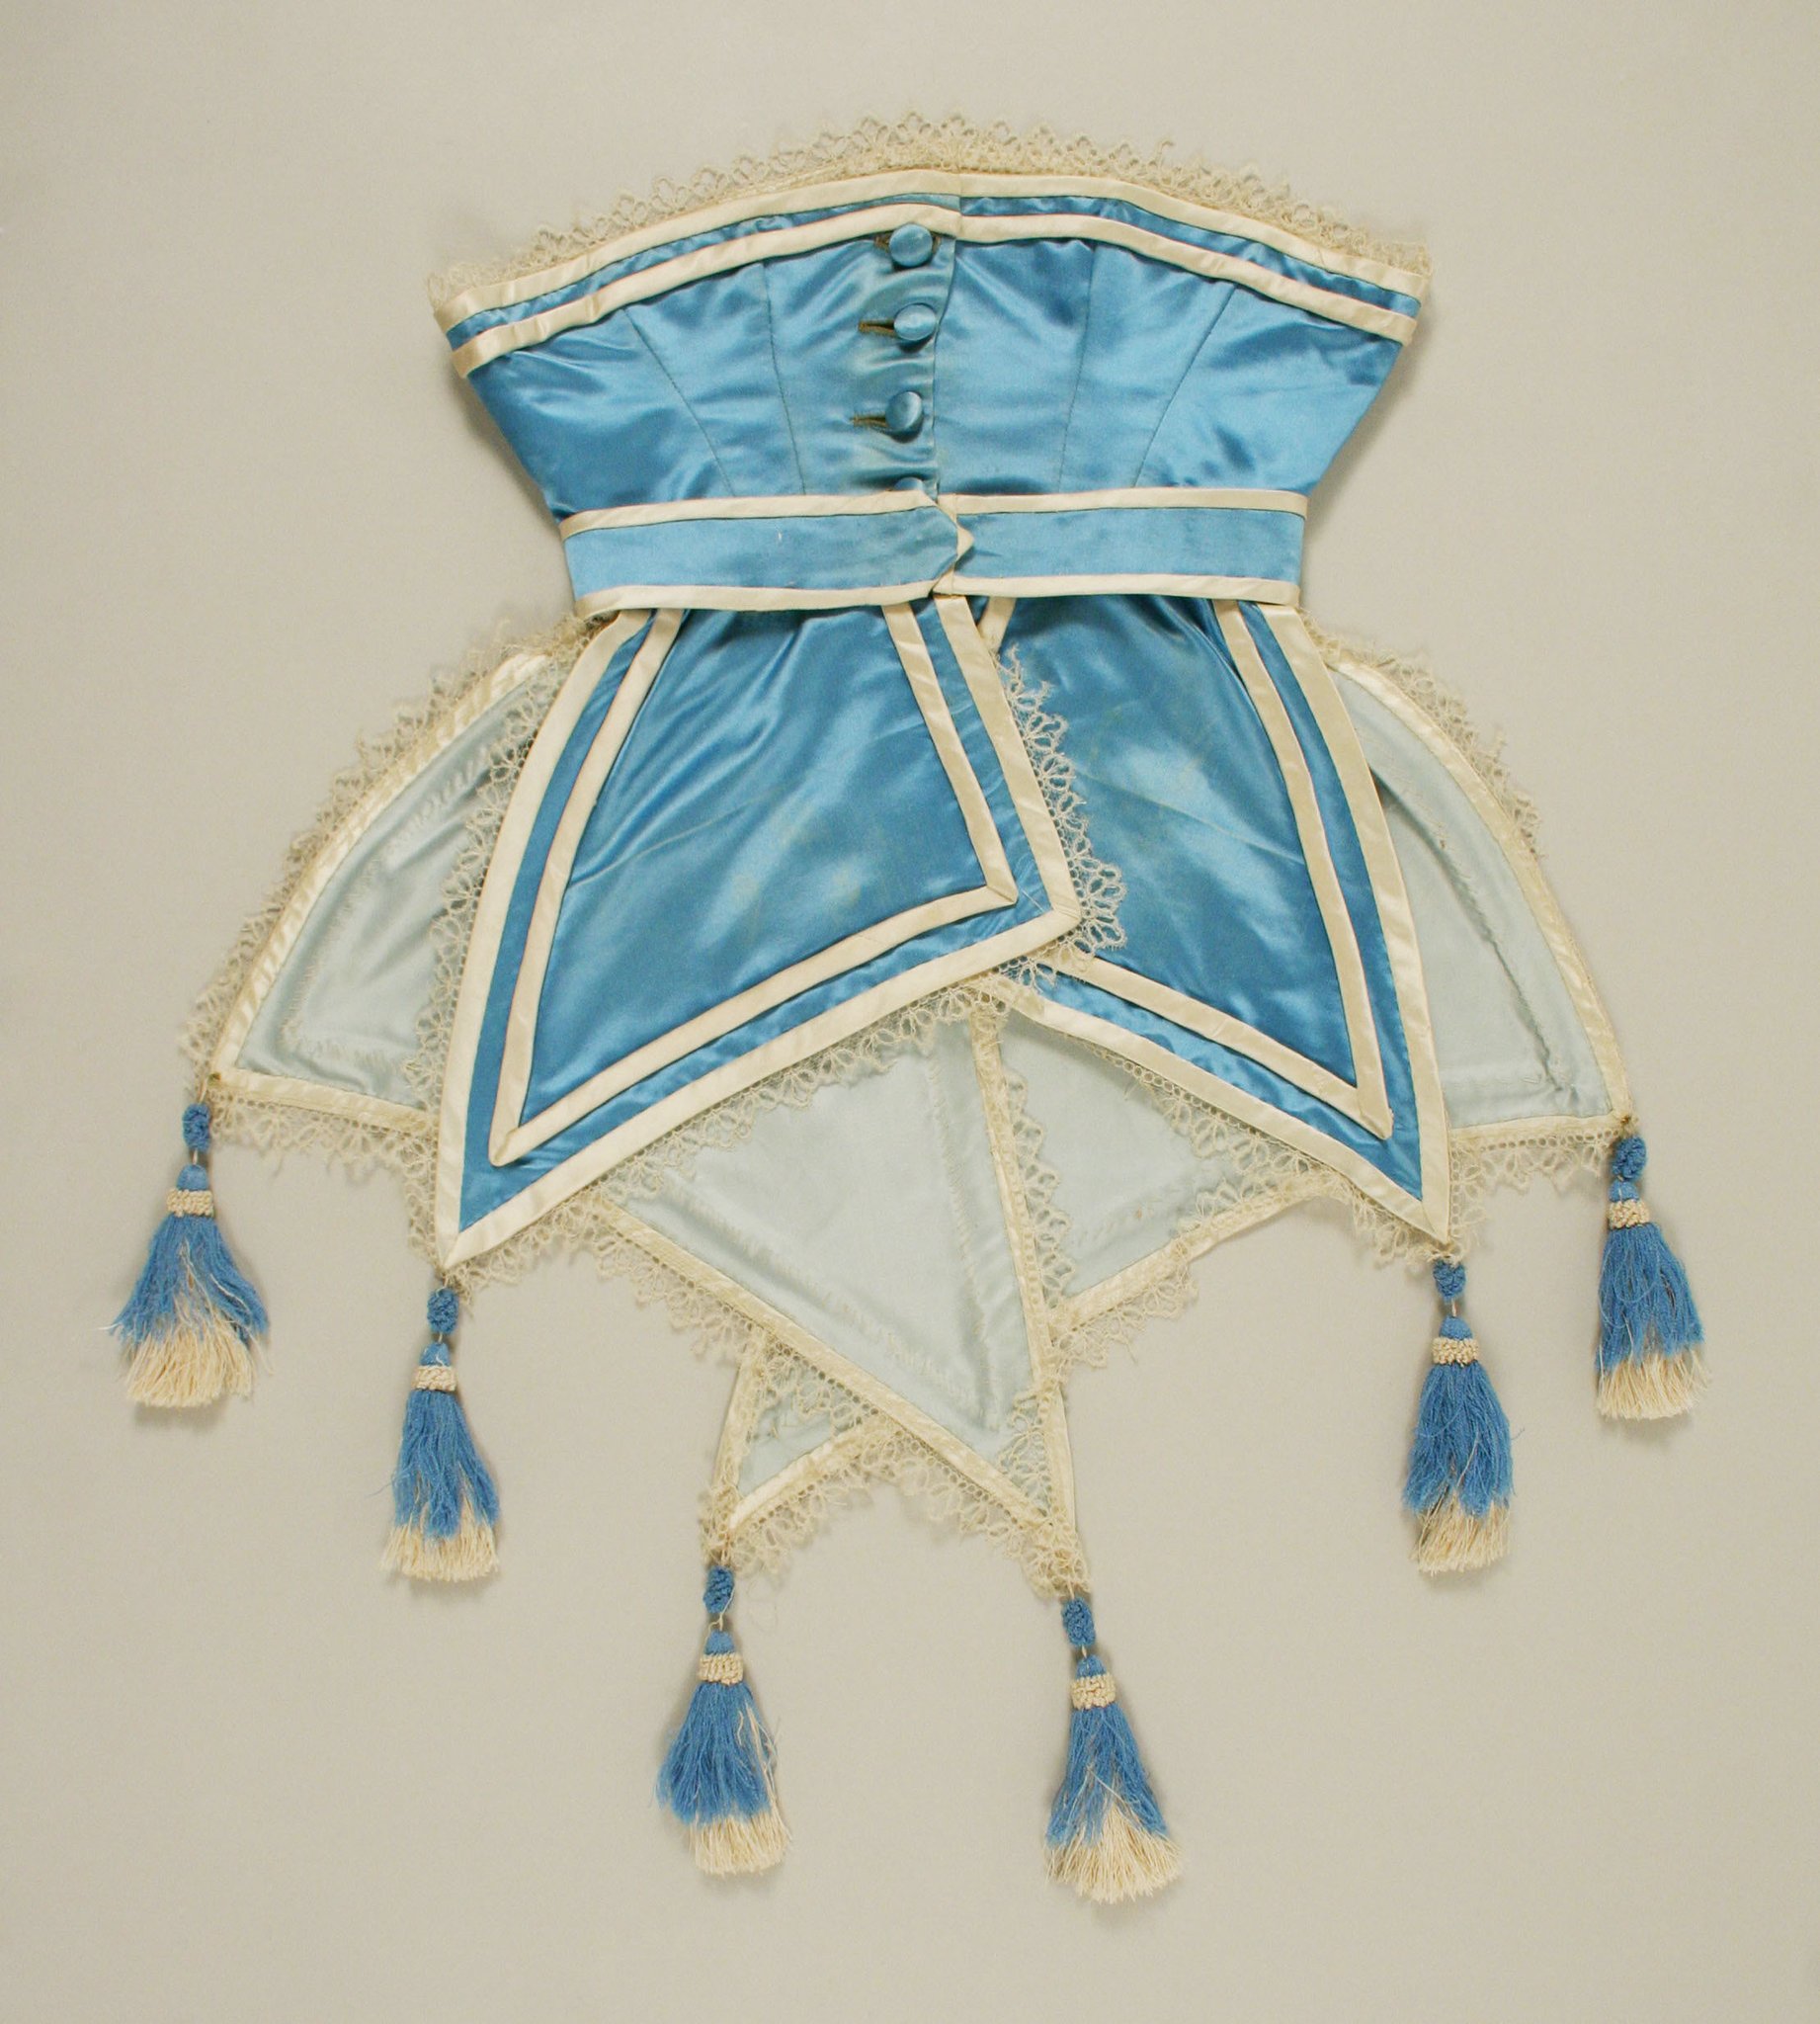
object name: corselet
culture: french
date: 1867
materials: silk